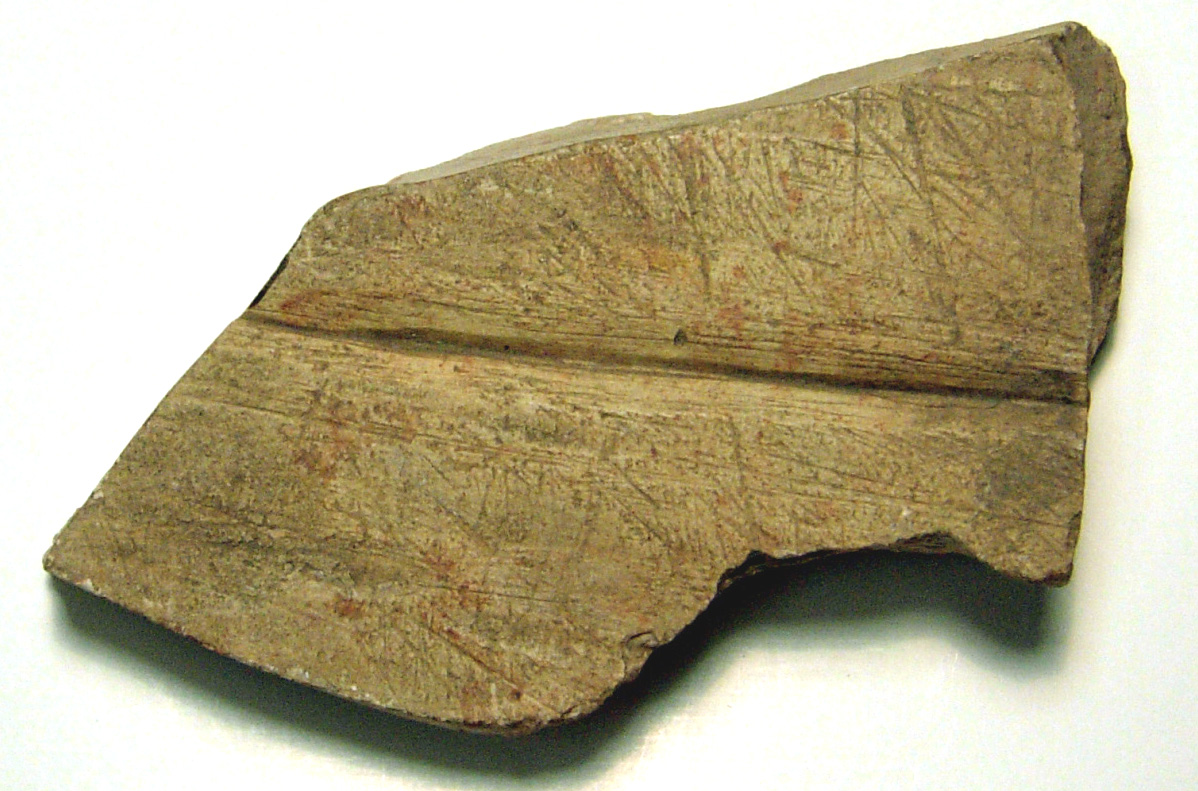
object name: relief, tomb of nespekashuty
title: Raised relief fragment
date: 664-610 BCE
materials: limestone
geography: egypt